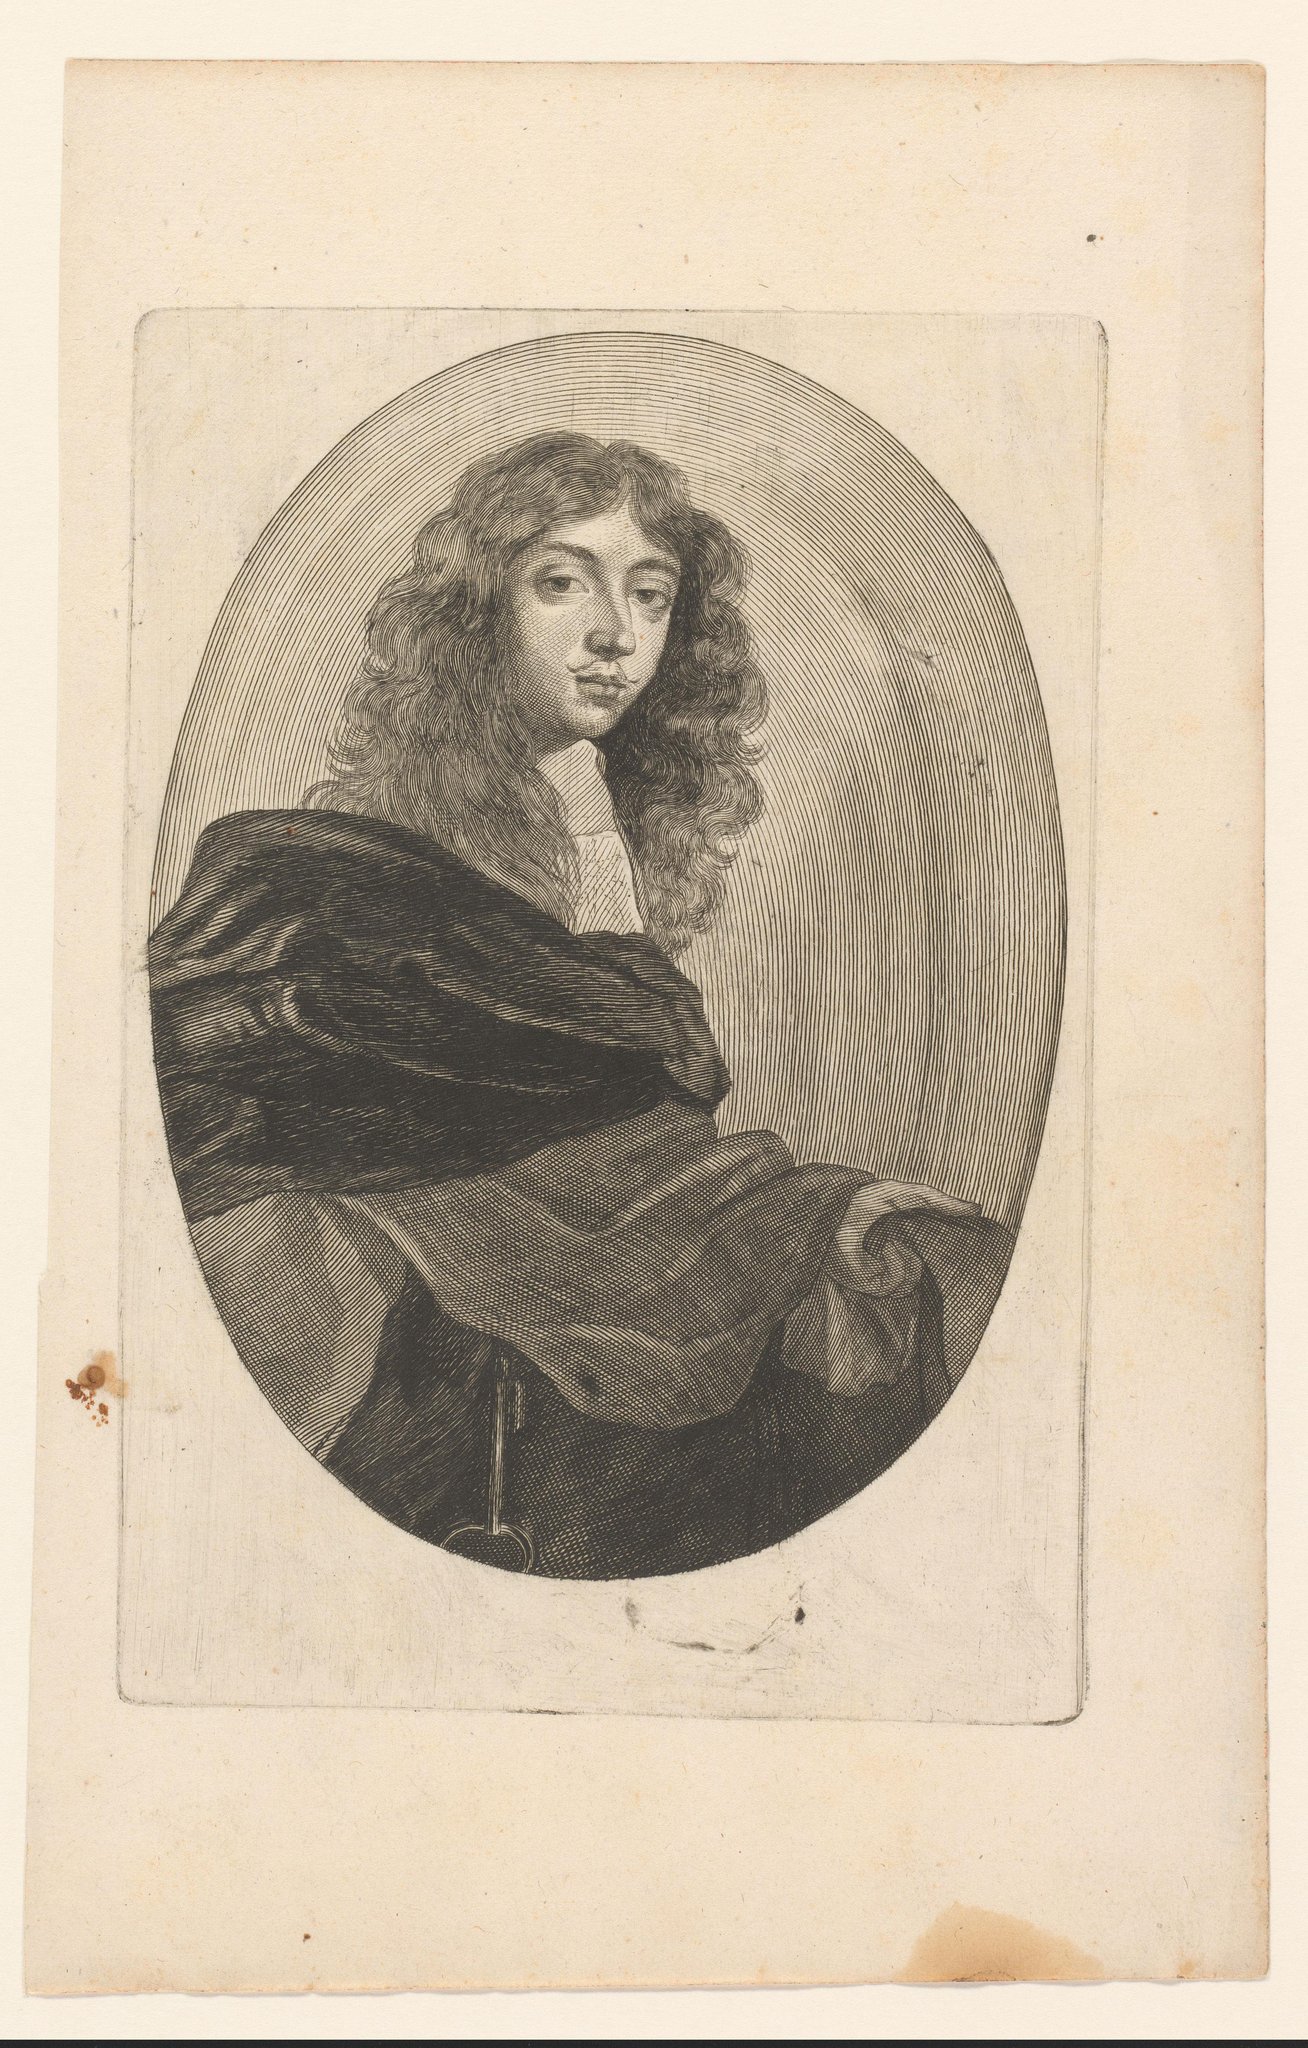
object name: print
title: Portret van een onbekende man met lang haar en sleutel aan zijn mantel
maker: Anonymous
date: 1650-1720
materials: paper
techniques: engraving, etching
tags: moustache, key, historical persons not known by name